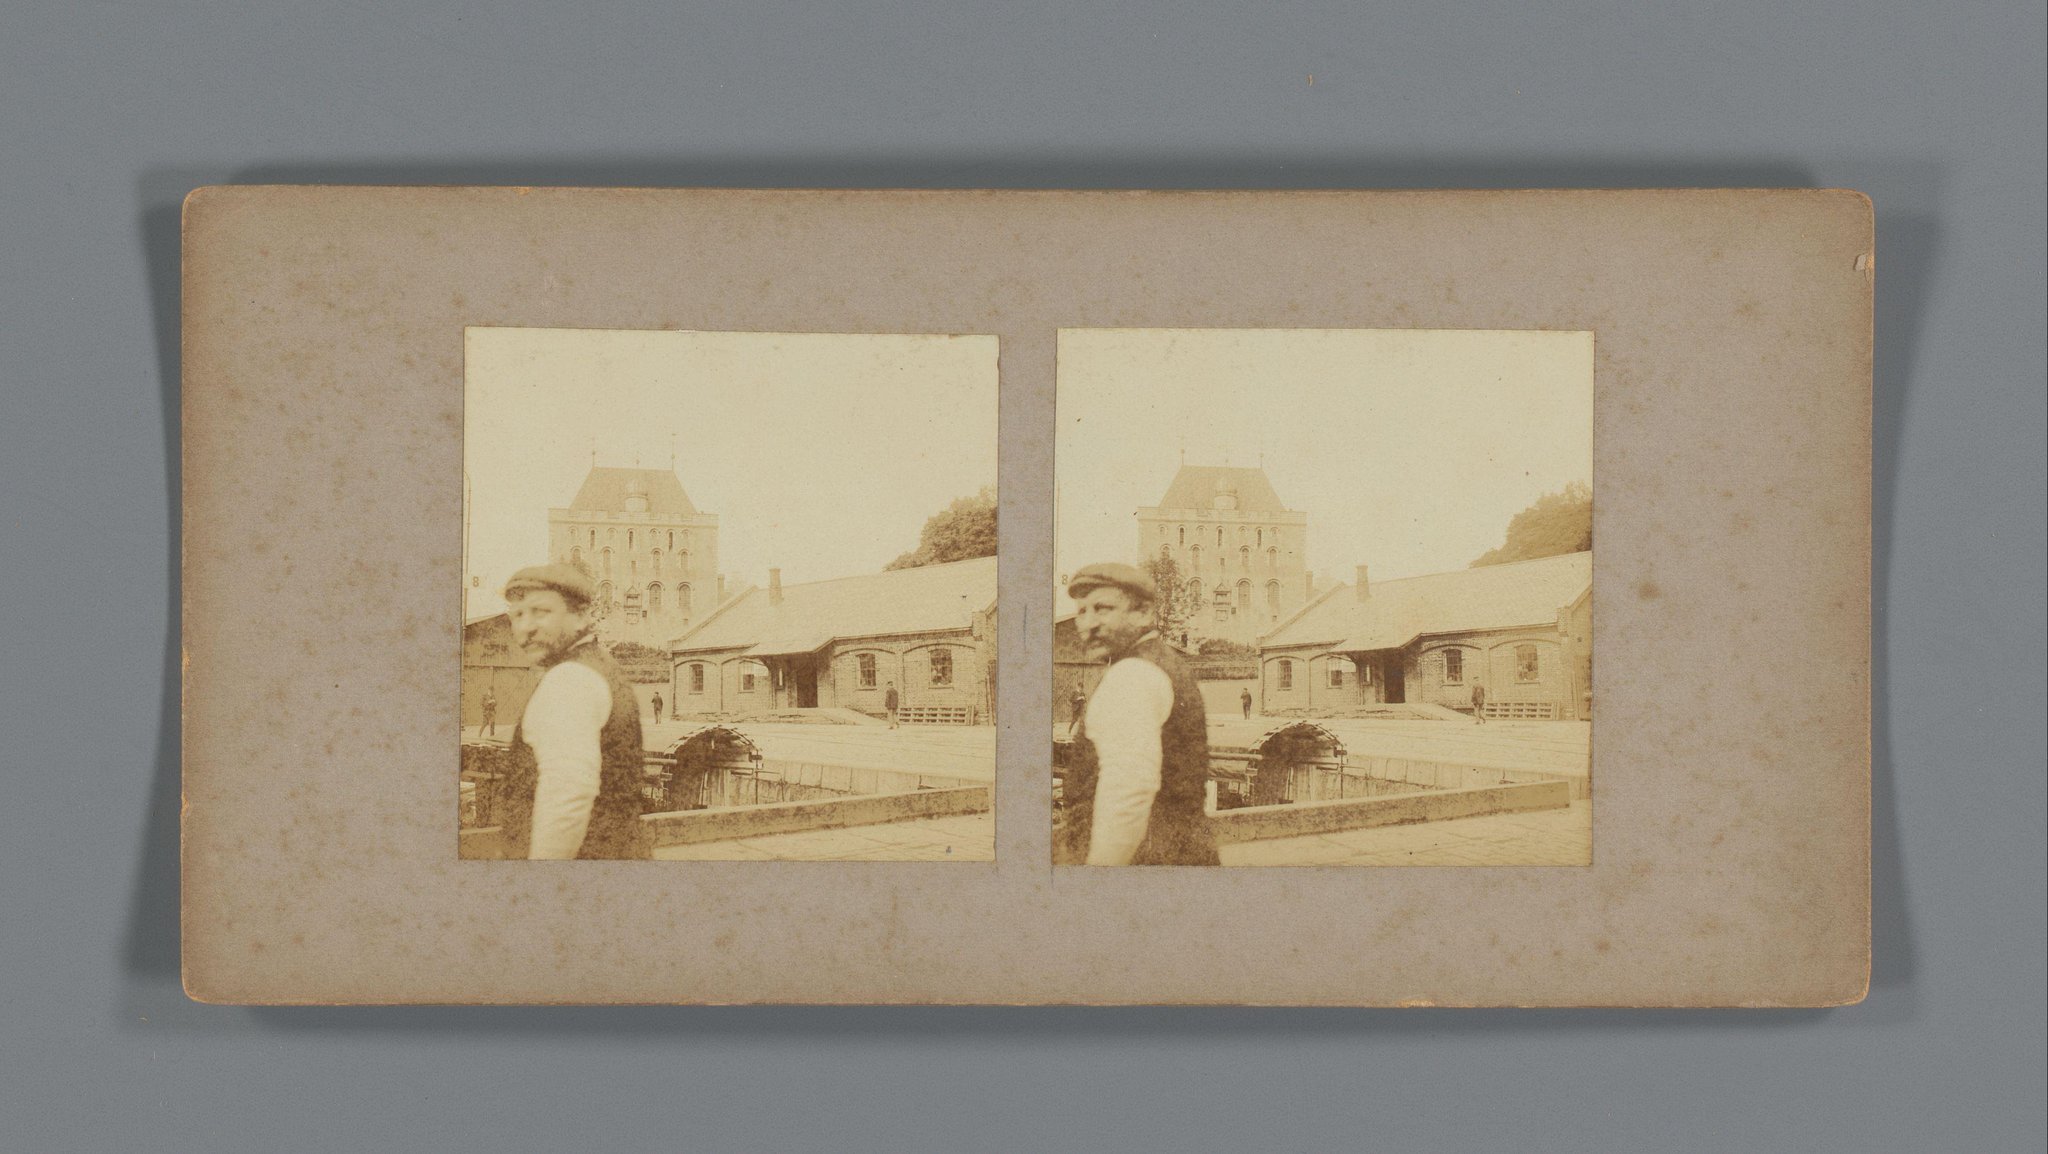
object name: stereograph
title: Vesting Bergenhus in Bergen, Noorwegen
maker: Anonymous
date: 1882-1890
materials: cardboard, photographic support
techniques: gelatin silver print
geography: bergen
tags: fortress, adult man